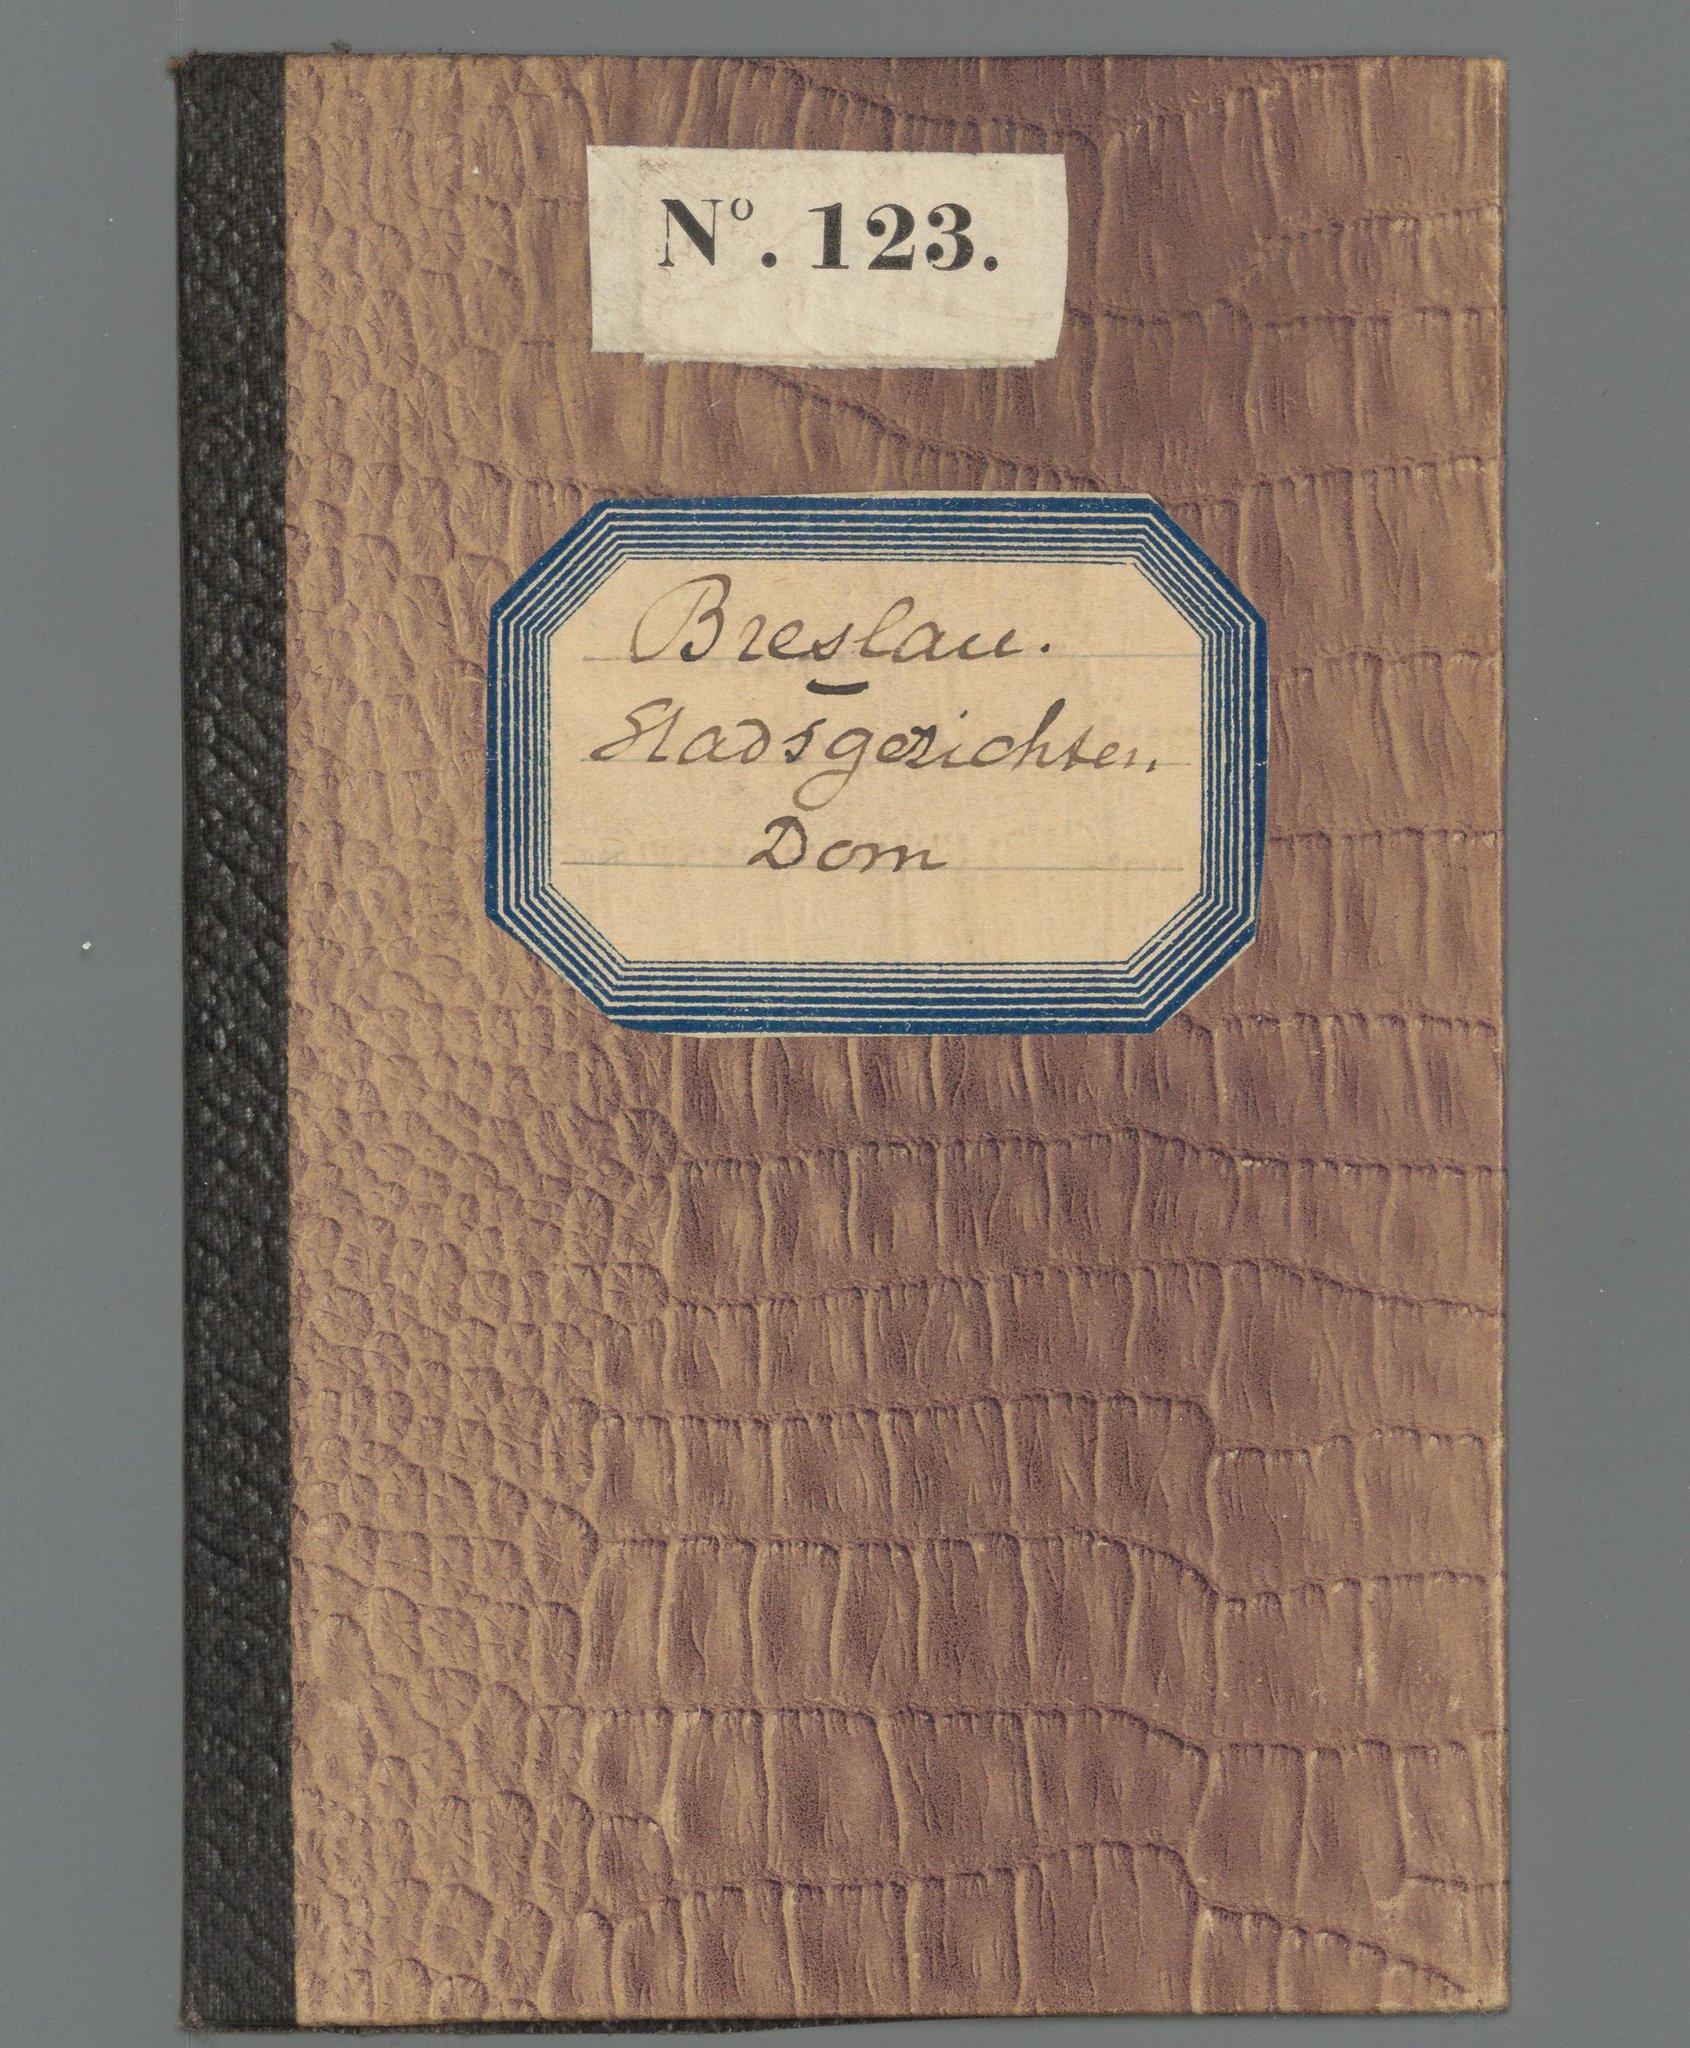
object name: wrapper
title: Breslau. Stadsgezichten. Dom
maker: Anonymous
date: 1900-1950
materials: cardboard, paper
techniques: lithograph, writing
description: In de omslag zit een kaart ingestoken met daarop een korte beschrijving van de inhoud.